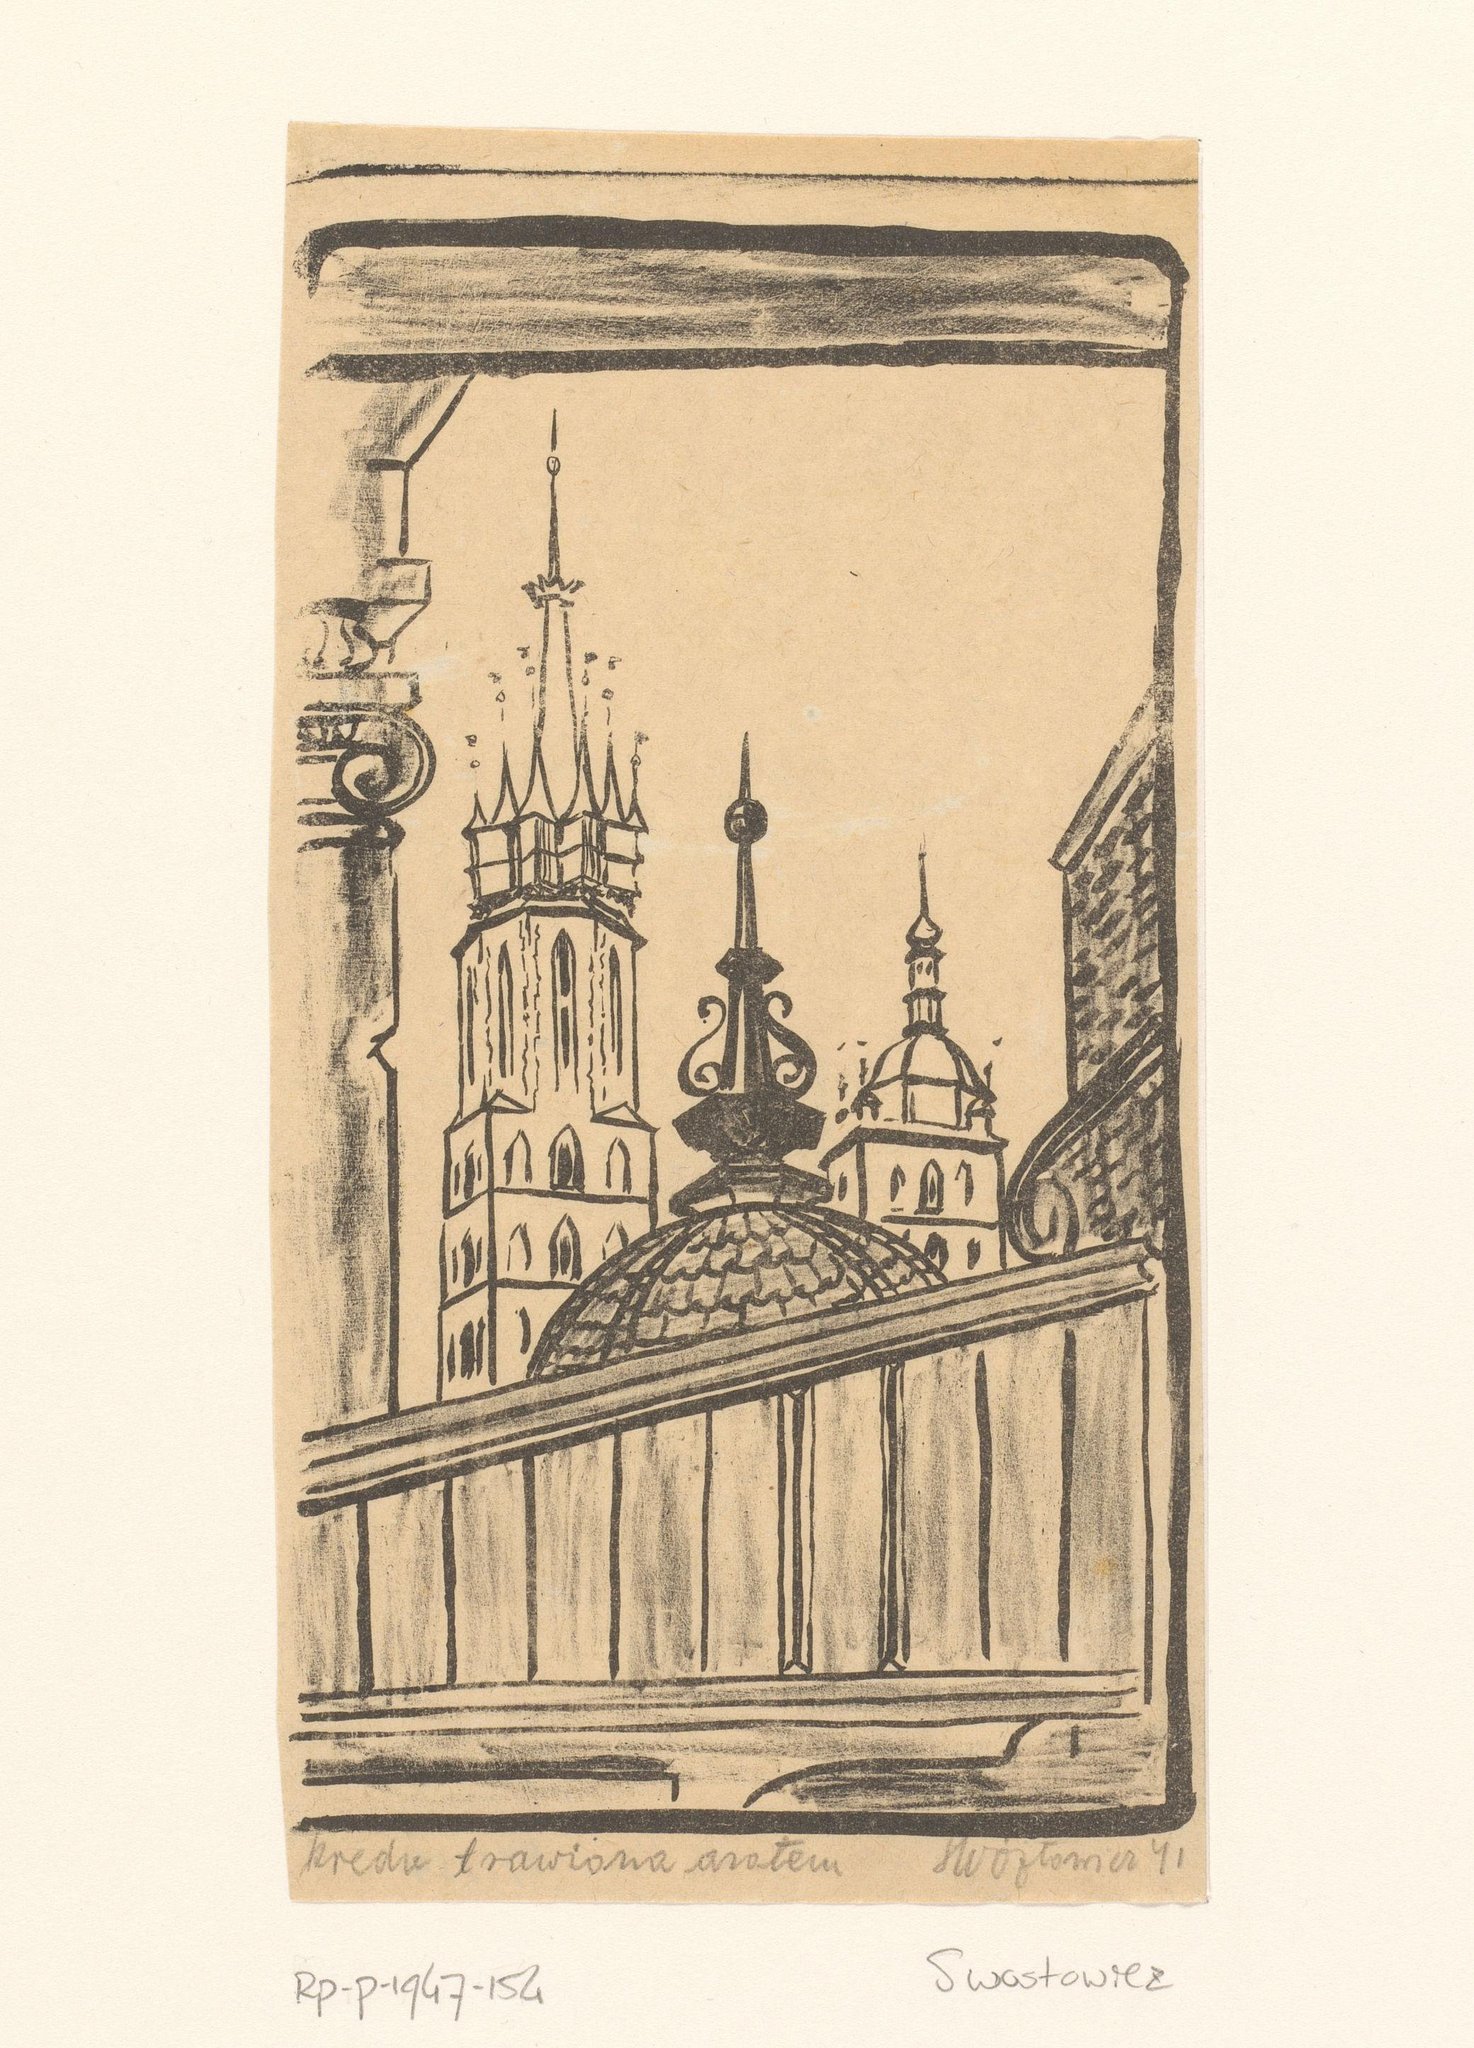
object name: print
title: Gezicht op daken en torens, waarschijnlijk Praag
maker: swostowiez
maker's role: print maker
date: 1841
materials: paper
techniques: lithograph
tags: city-view, and landscape with man-made constructions, roof (of house or building), prague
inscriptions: collector's mark: Lugt 2228, inscription: ‘[...] [Swostowiez 41]’